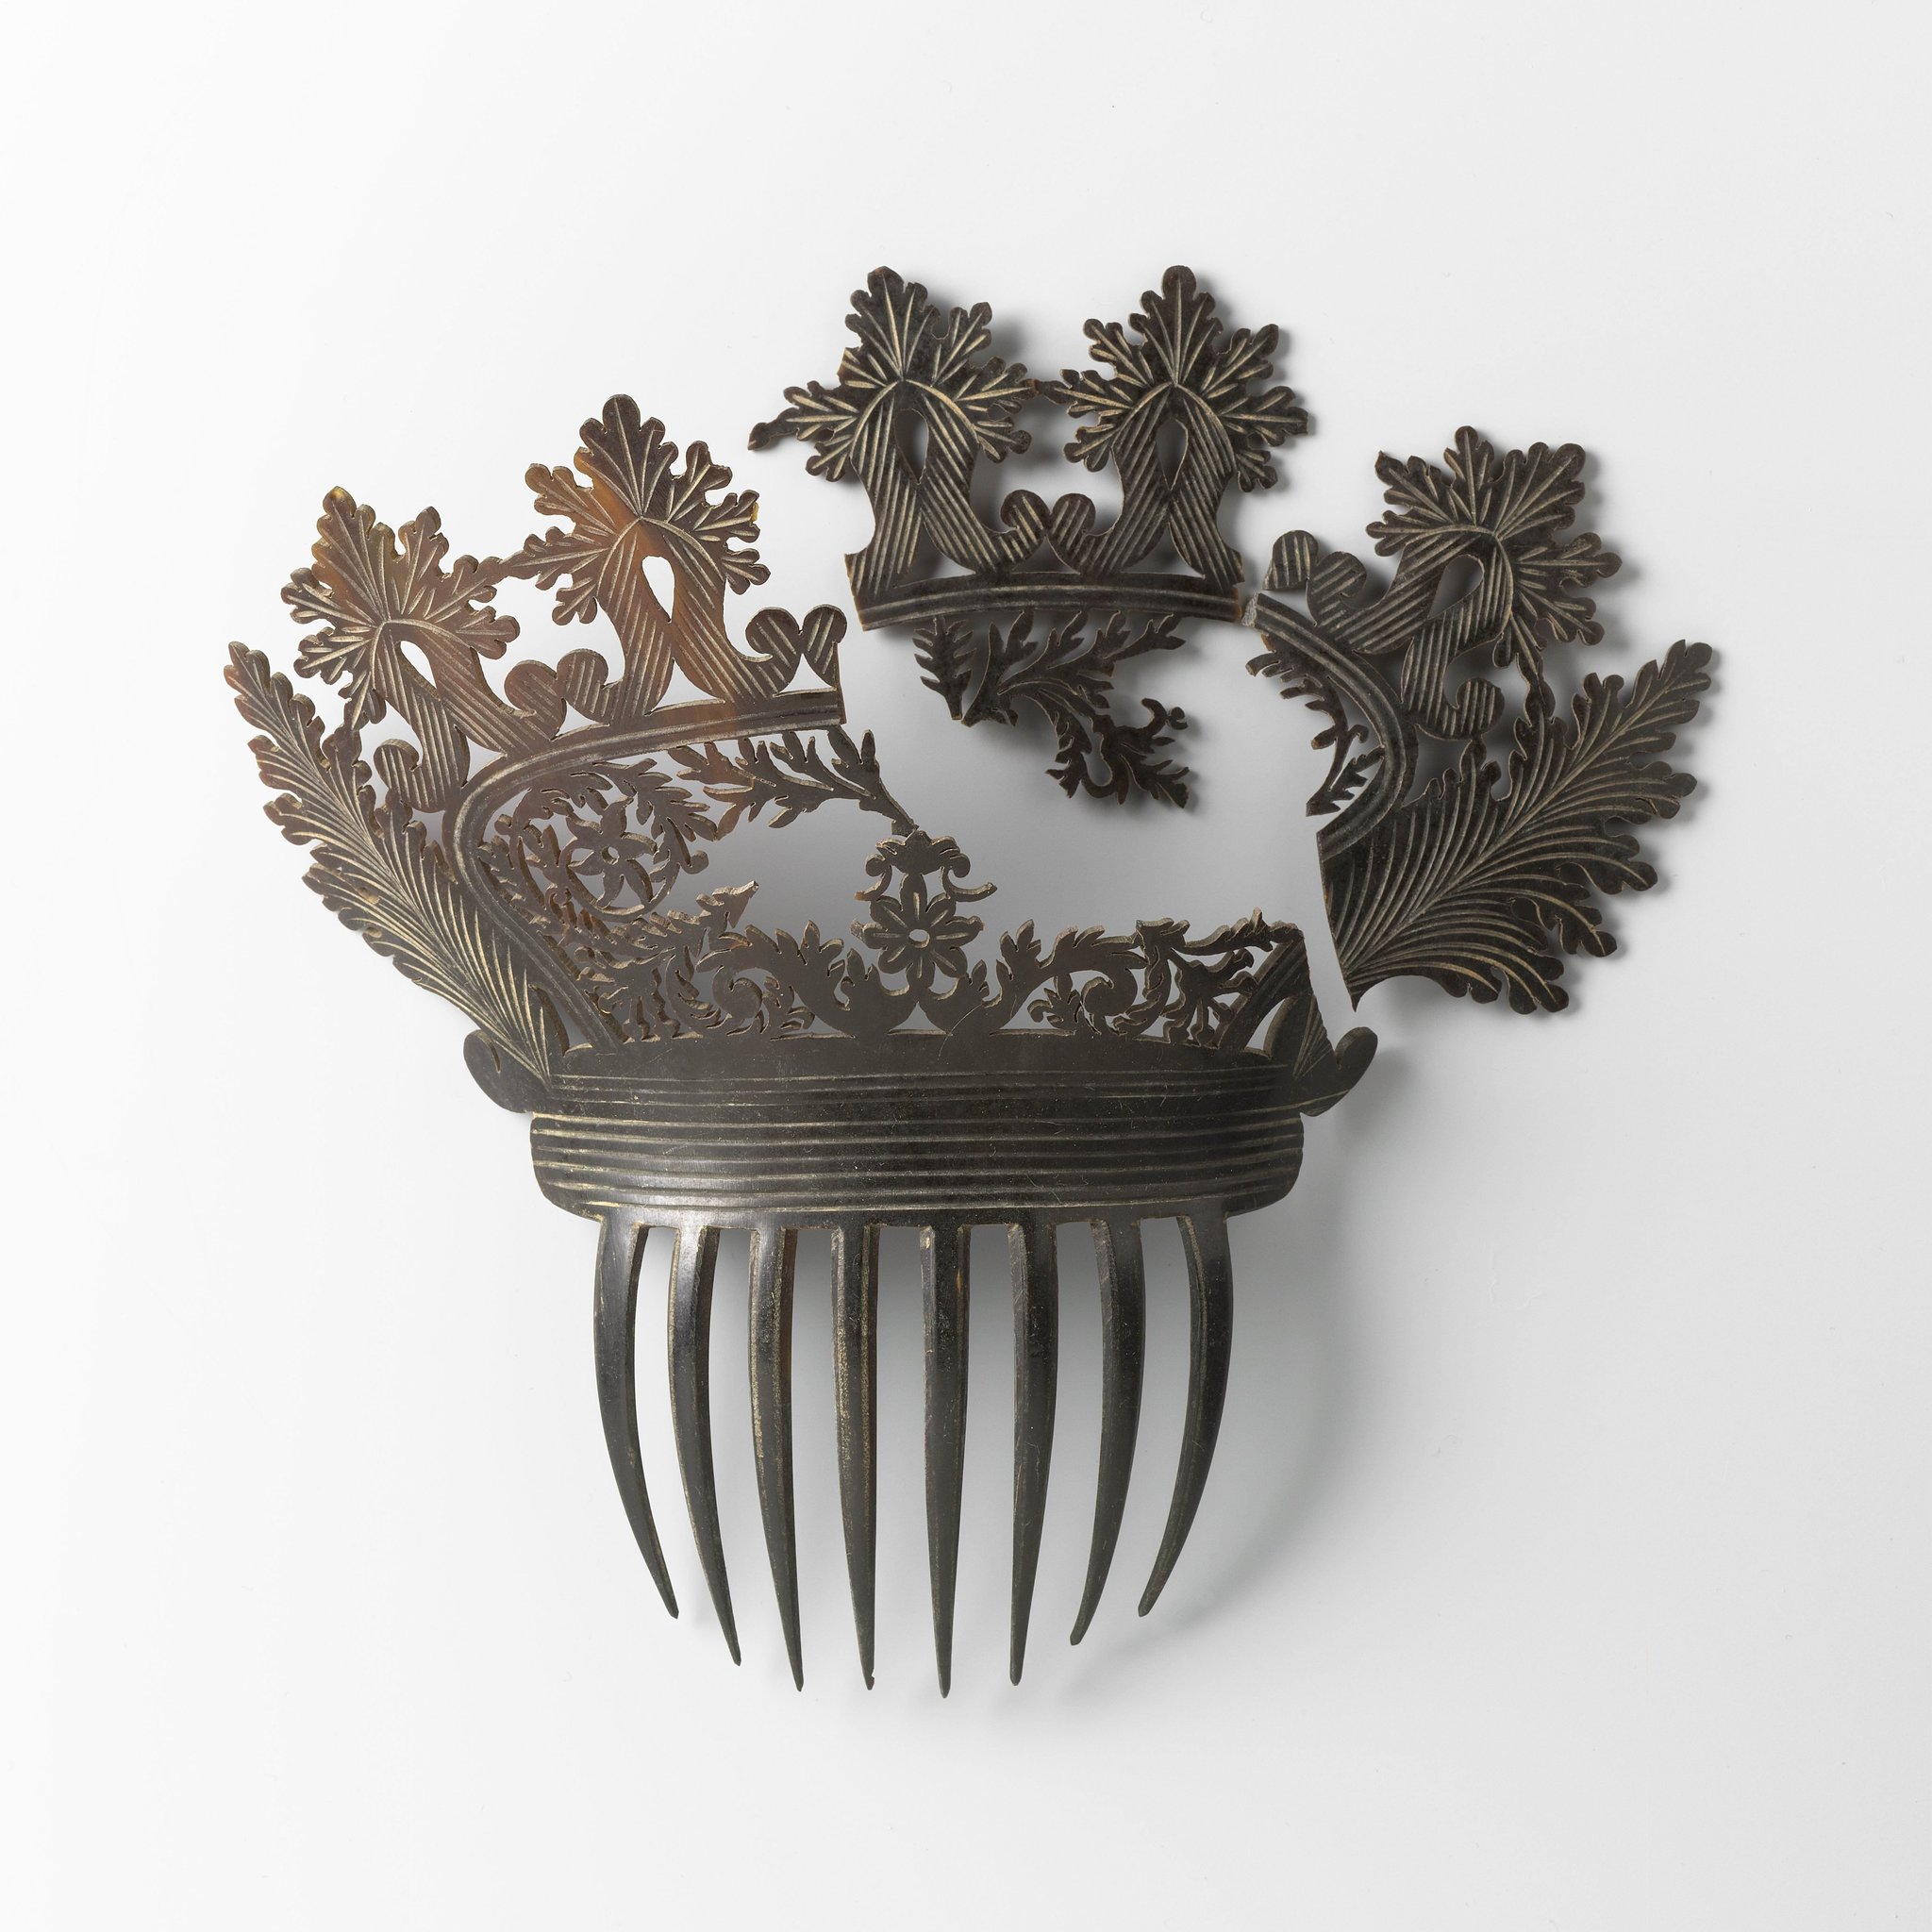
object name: comb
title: Haarkam van schildpad en hoorn met rijk gesneden rug, acht tanden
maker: Anonymous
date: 1800-1830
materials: horn, shell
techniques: embroidery, filing, polish, pressing, sawing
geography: netherlands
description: Haarkam van donker schildpad of hoorn met hoog opstaande rijk gesneden rug, blad- en bloemranken, bekroond met festoenen. Acht tanden.